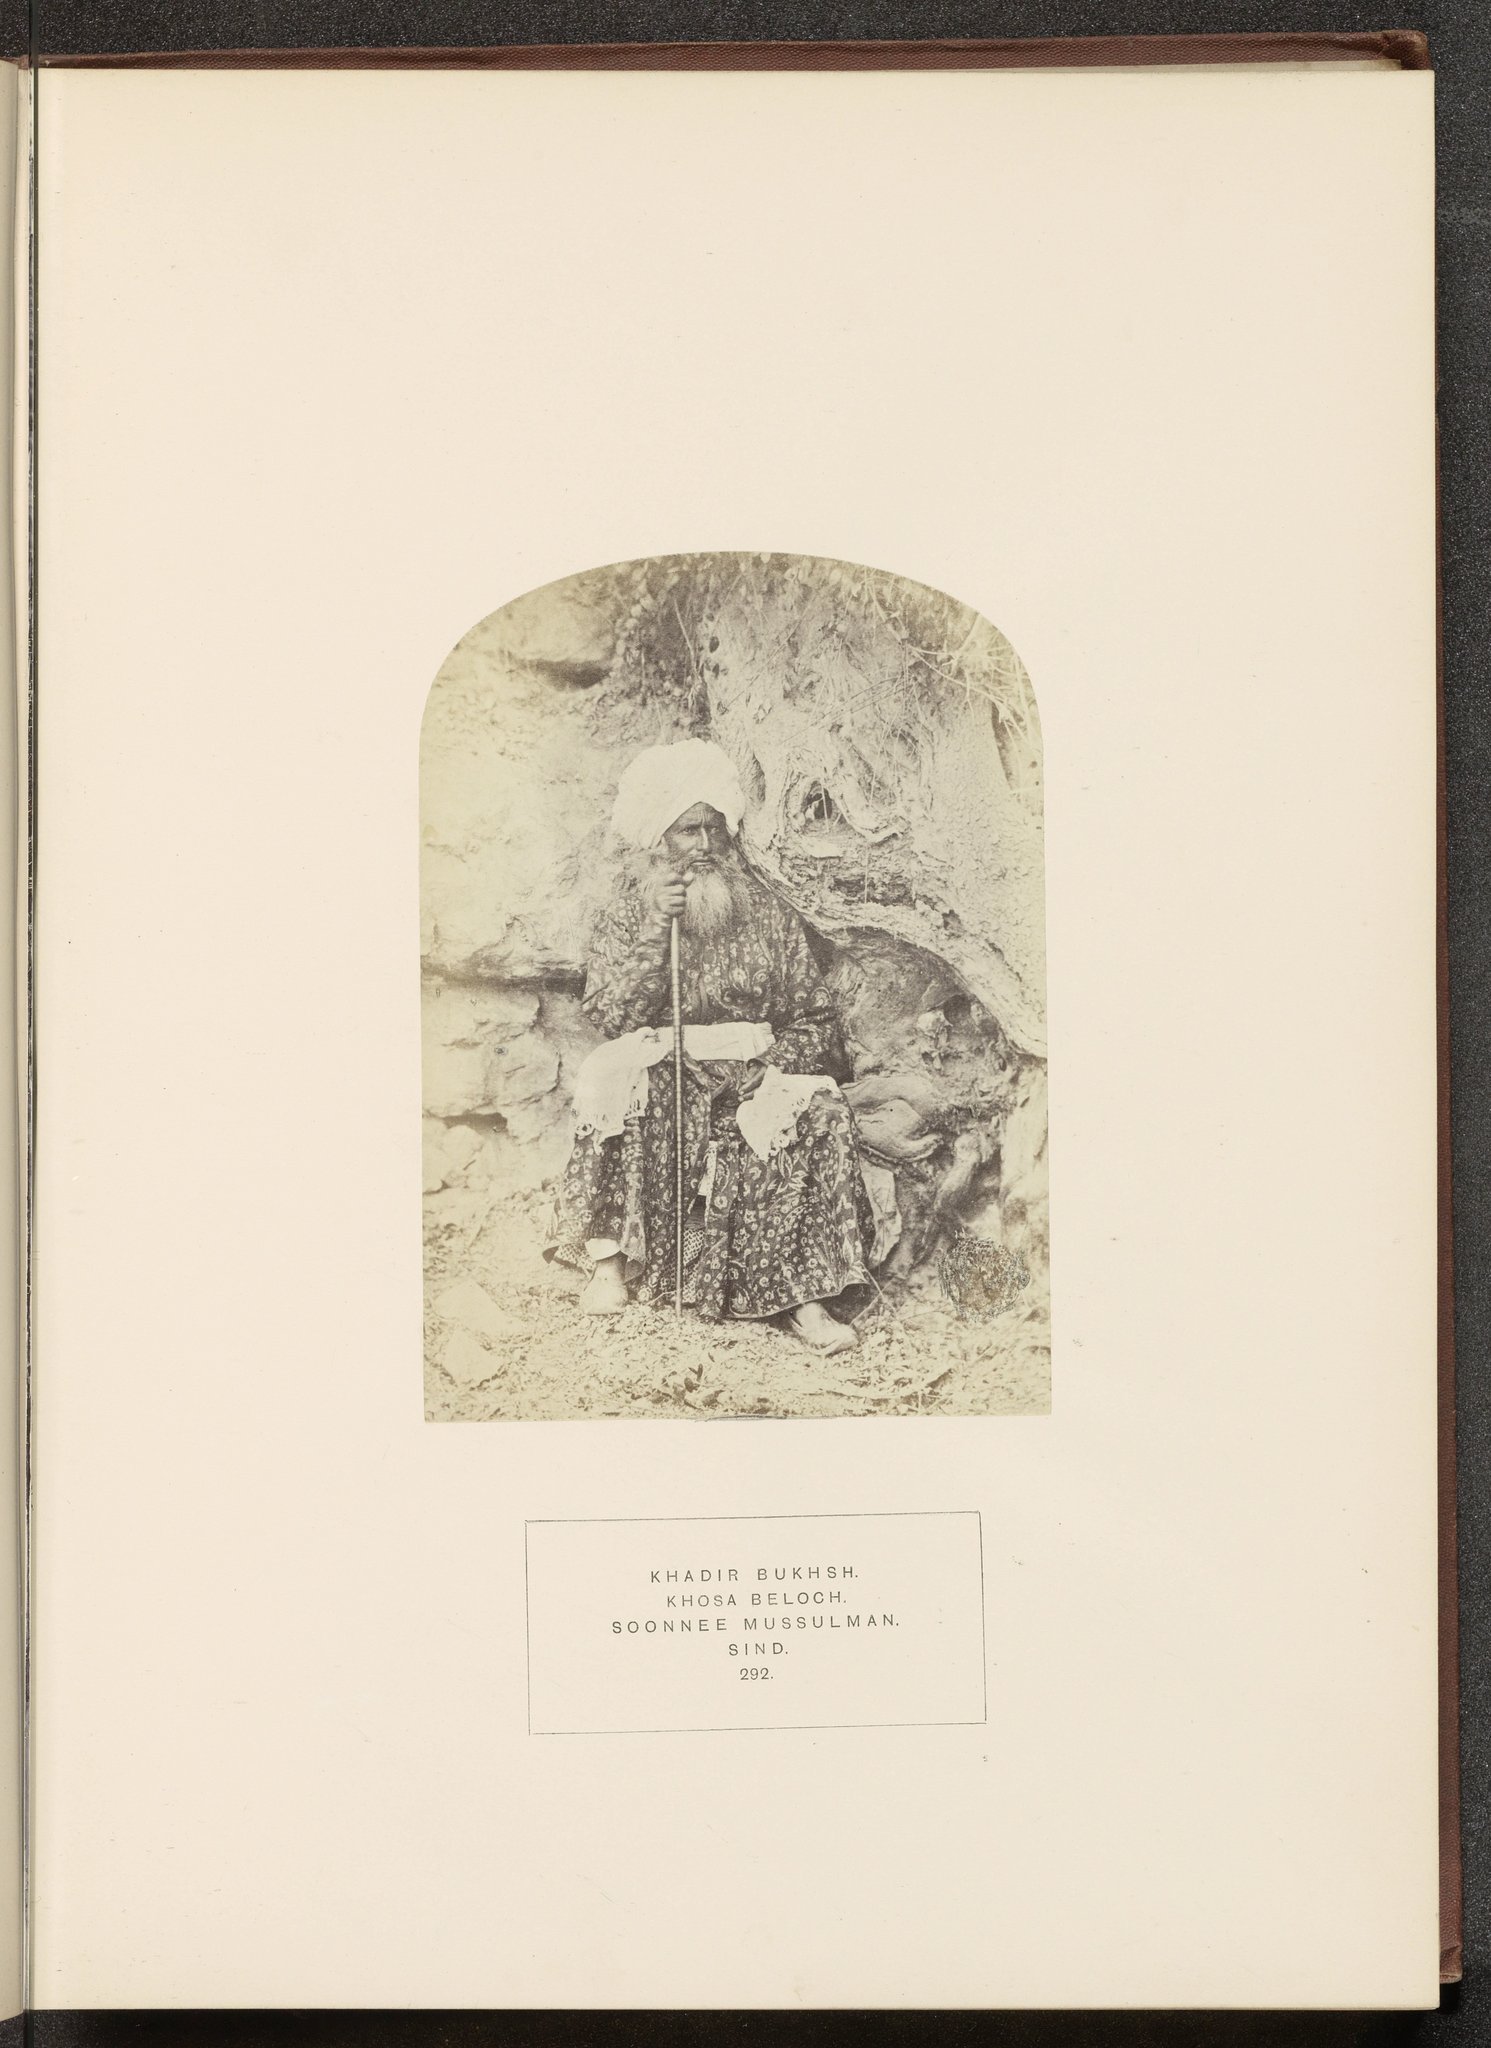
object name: page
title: Portrait of Khaddir Bukhsh, a landholder in Sindh, Pakistan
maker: henry charles baskerville tanner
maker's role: fotograaf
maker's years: 1835-1898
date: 1862-1872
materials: photographic support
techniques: albumen print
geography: sindh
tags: head-gear: turban, human races; peoples; nationalities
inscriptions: number: ‘292.’, inscription: ‘KHADIR BUKHSH./ KHOSA BELOCH./ SOONNEE MUSSULMAN./ SIND.’